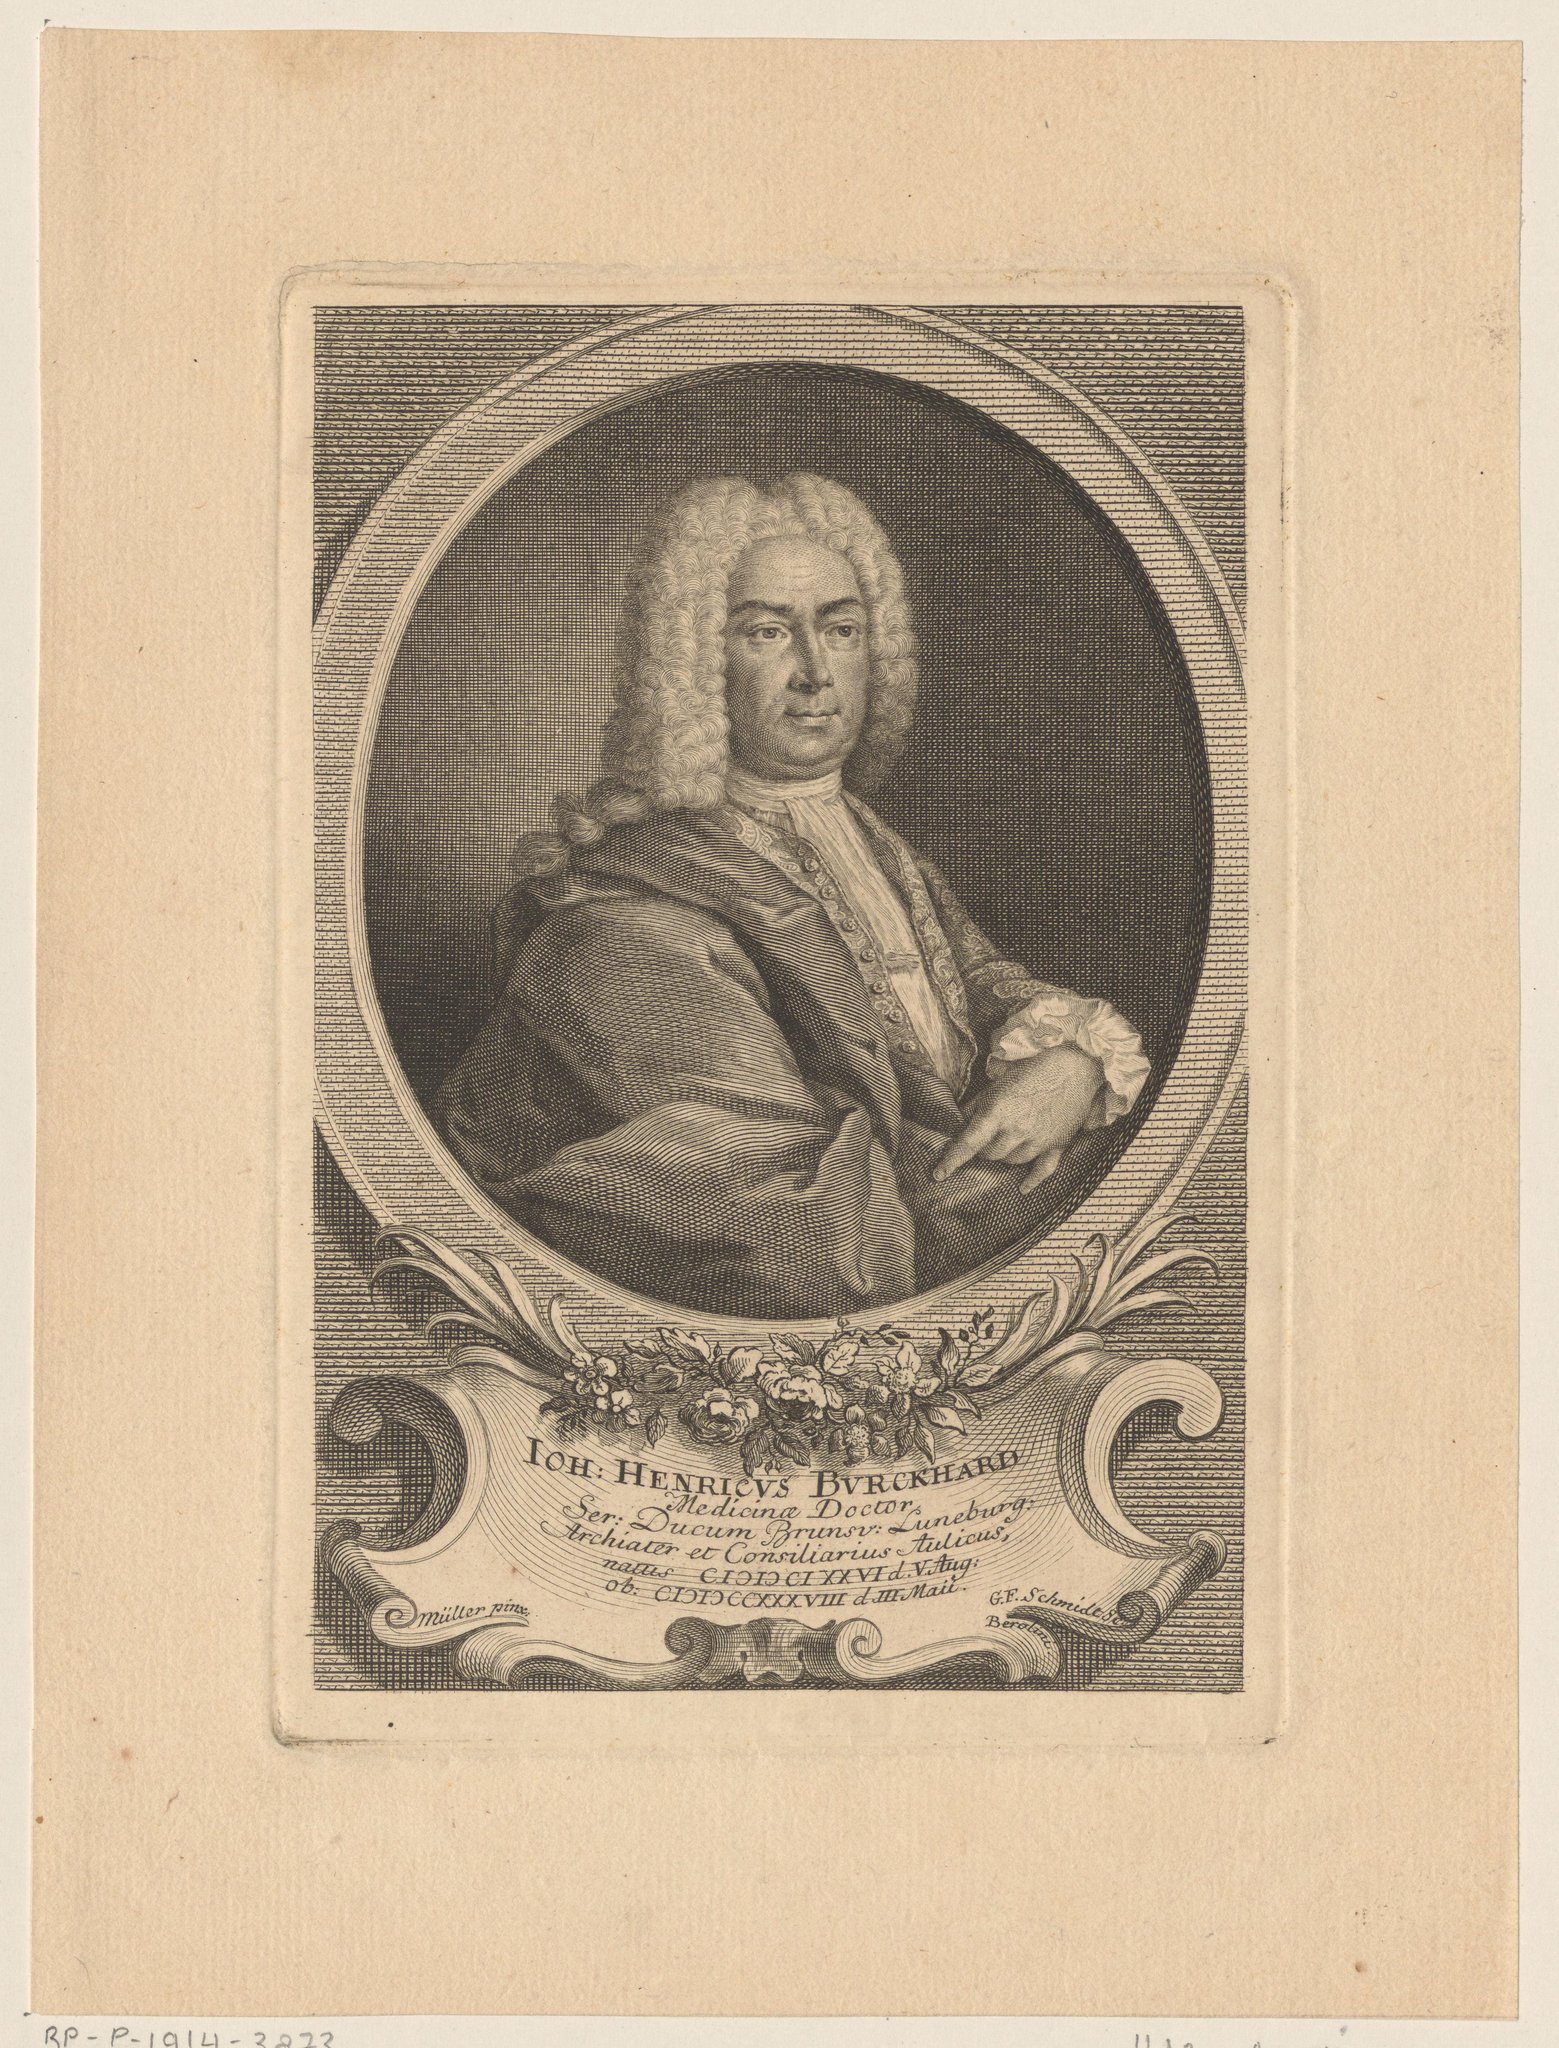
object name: print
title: Portret van Johann Heinrich Burckhard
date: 1738-1775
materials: paper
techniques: engraving, etching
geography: berlin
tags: historical persons, physician, doctor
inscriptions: collector's mark: Lugt 2228